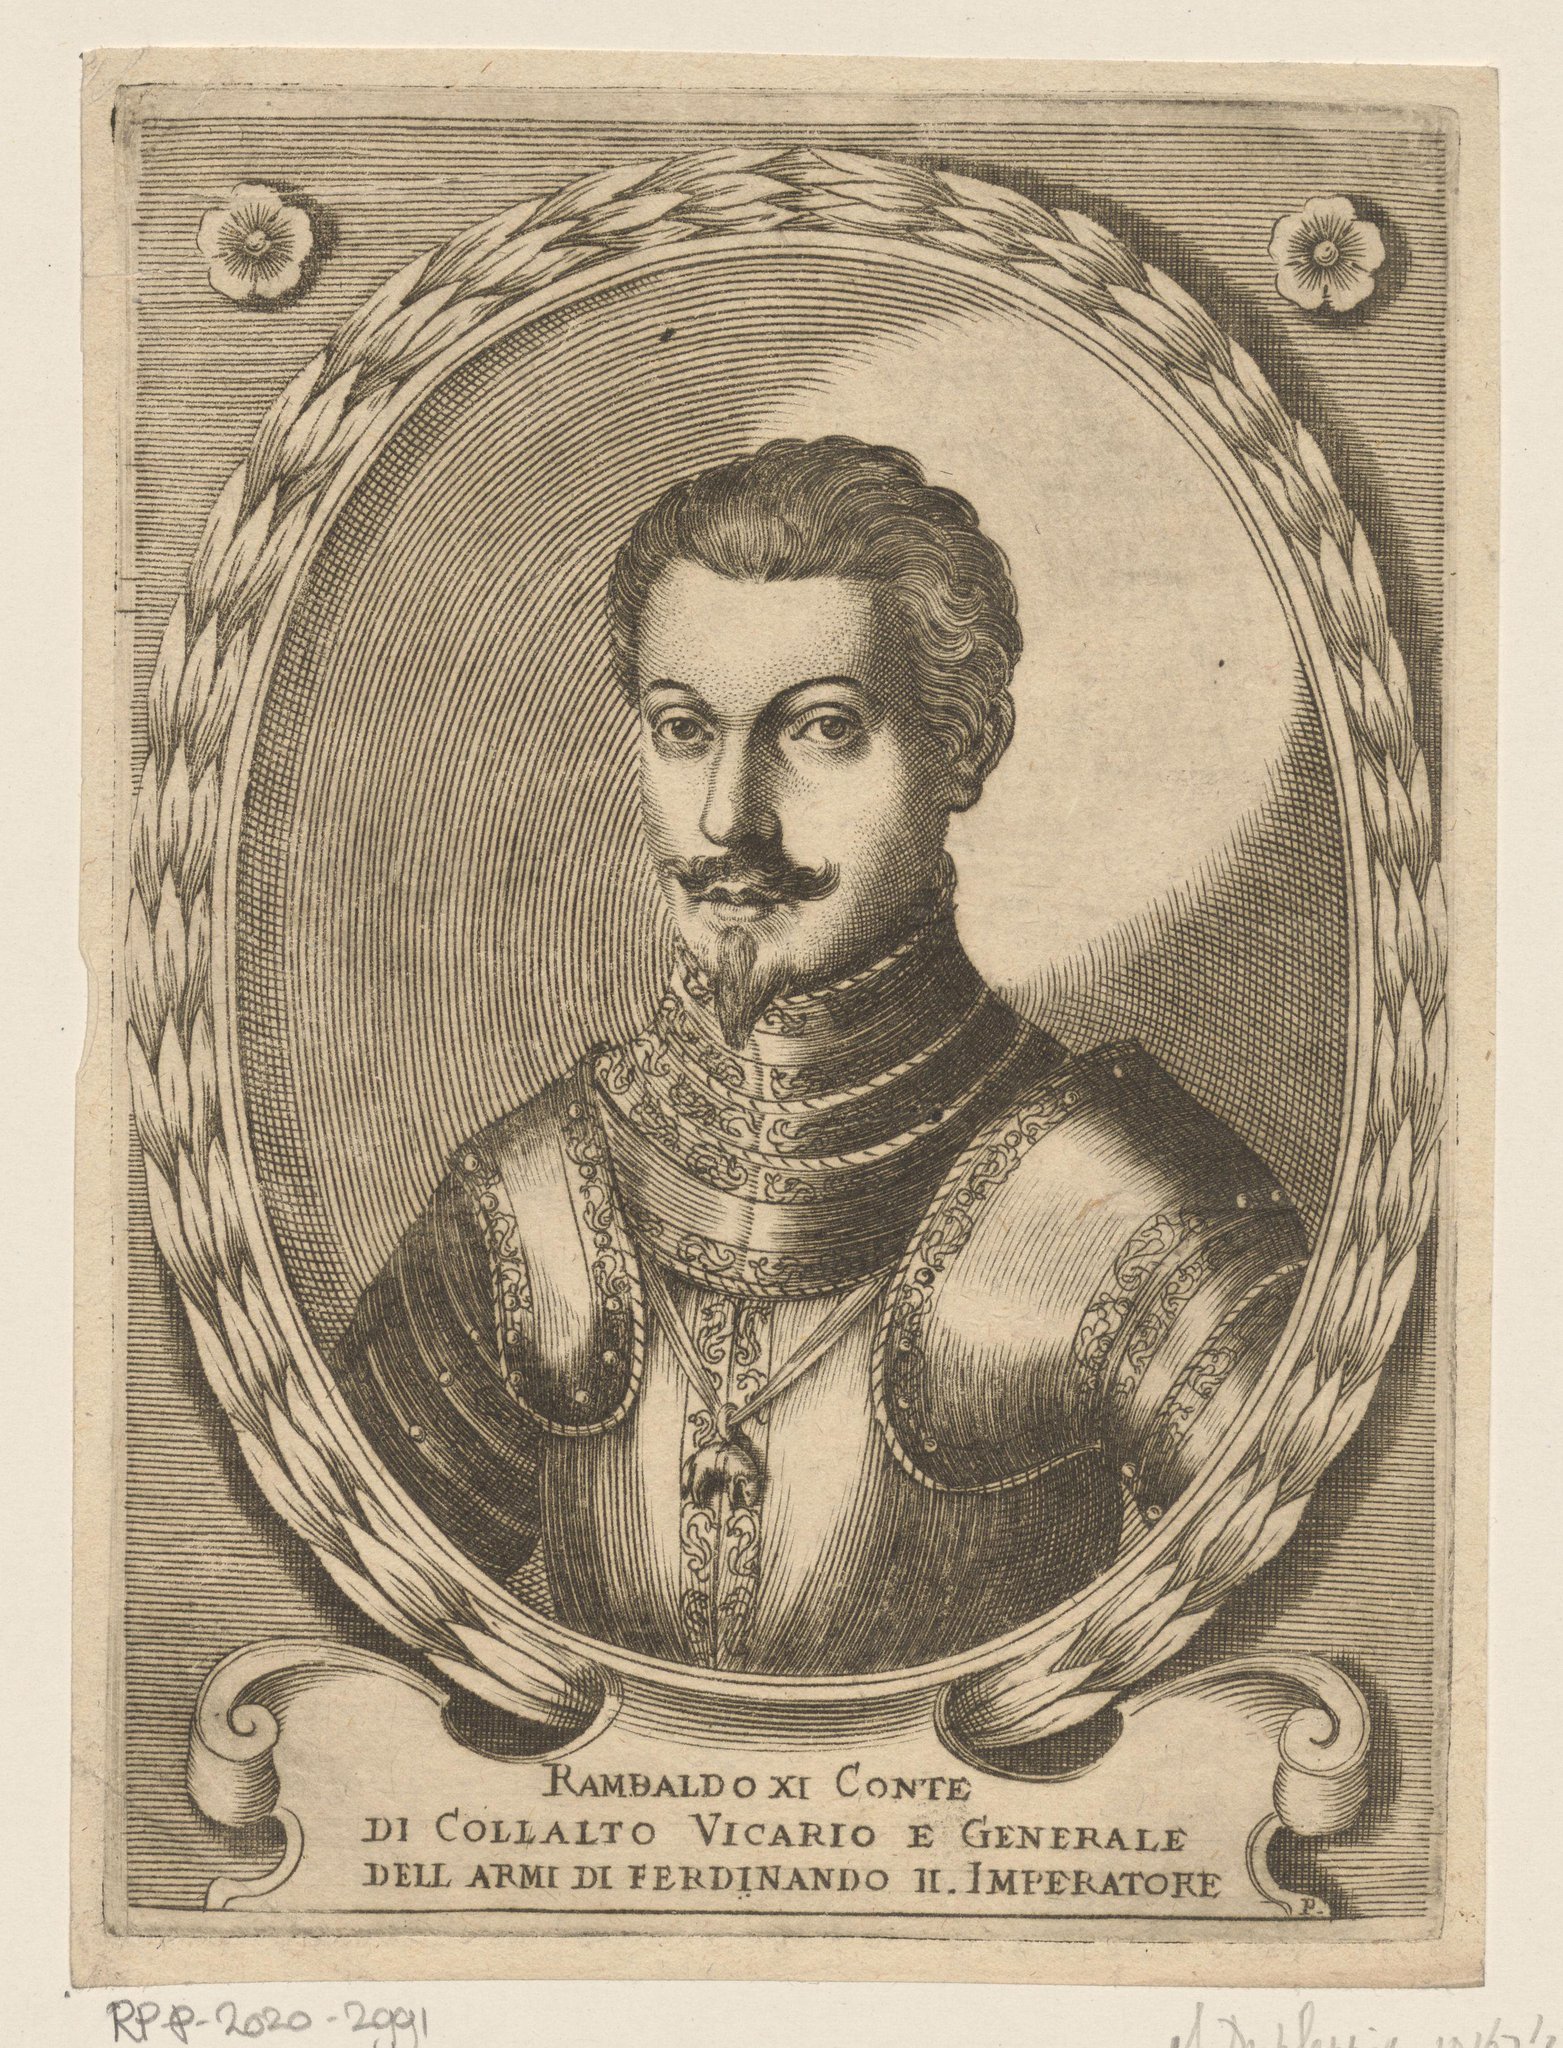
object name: print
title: Portret van Ramboldo van Collalto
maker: Anonymous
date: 1630-1699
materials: paper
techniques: engraving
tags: historical persons